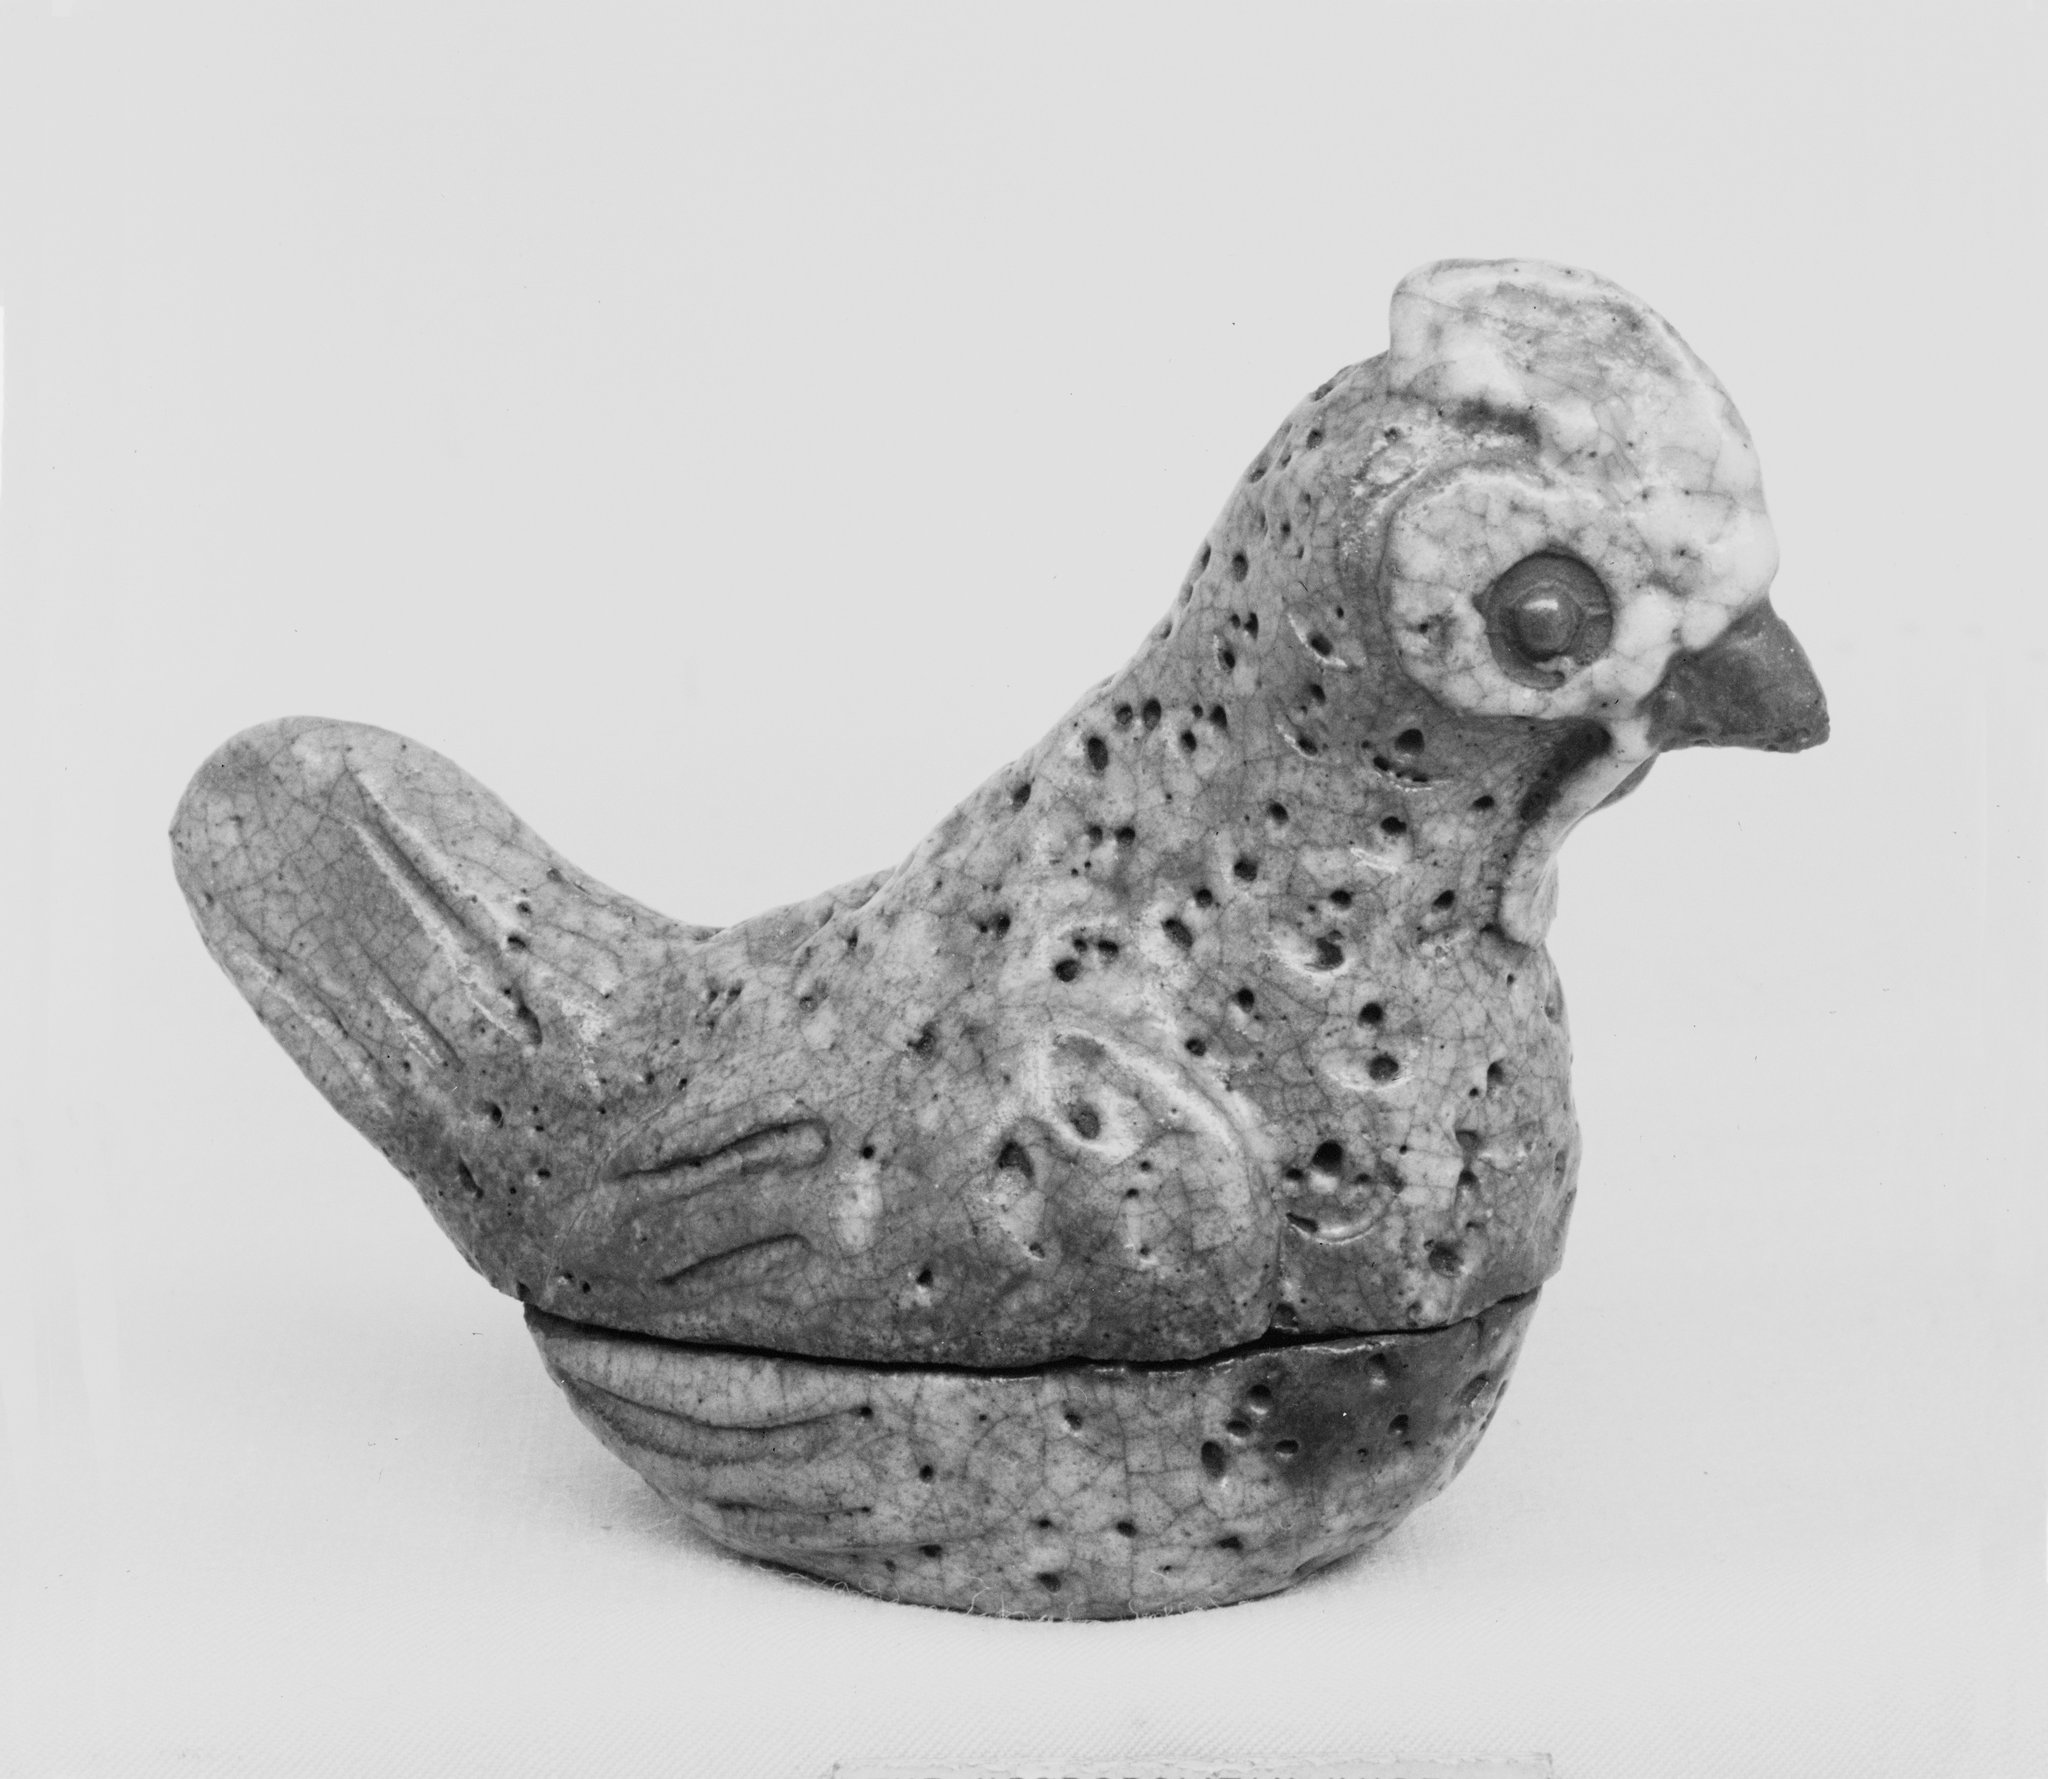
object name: incense box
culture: japanese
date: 1701-1800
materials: clay, glaze, paste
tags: birds